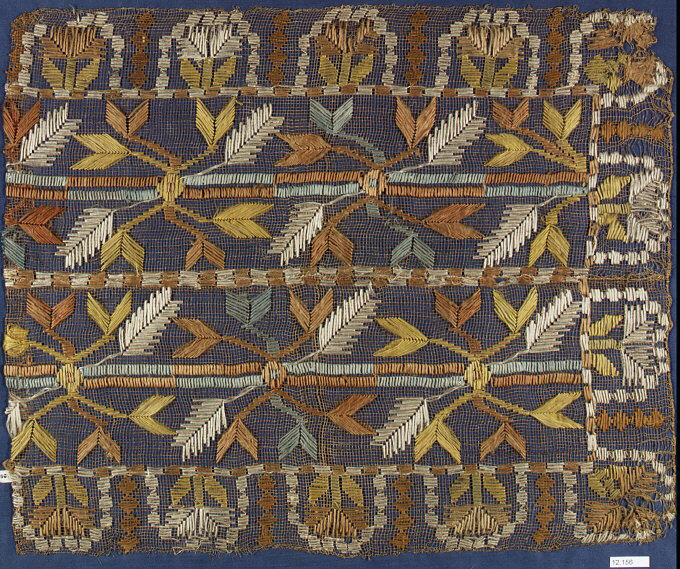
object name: scarf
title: End of a scarf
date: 1601-1700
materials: silk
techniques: embroidery